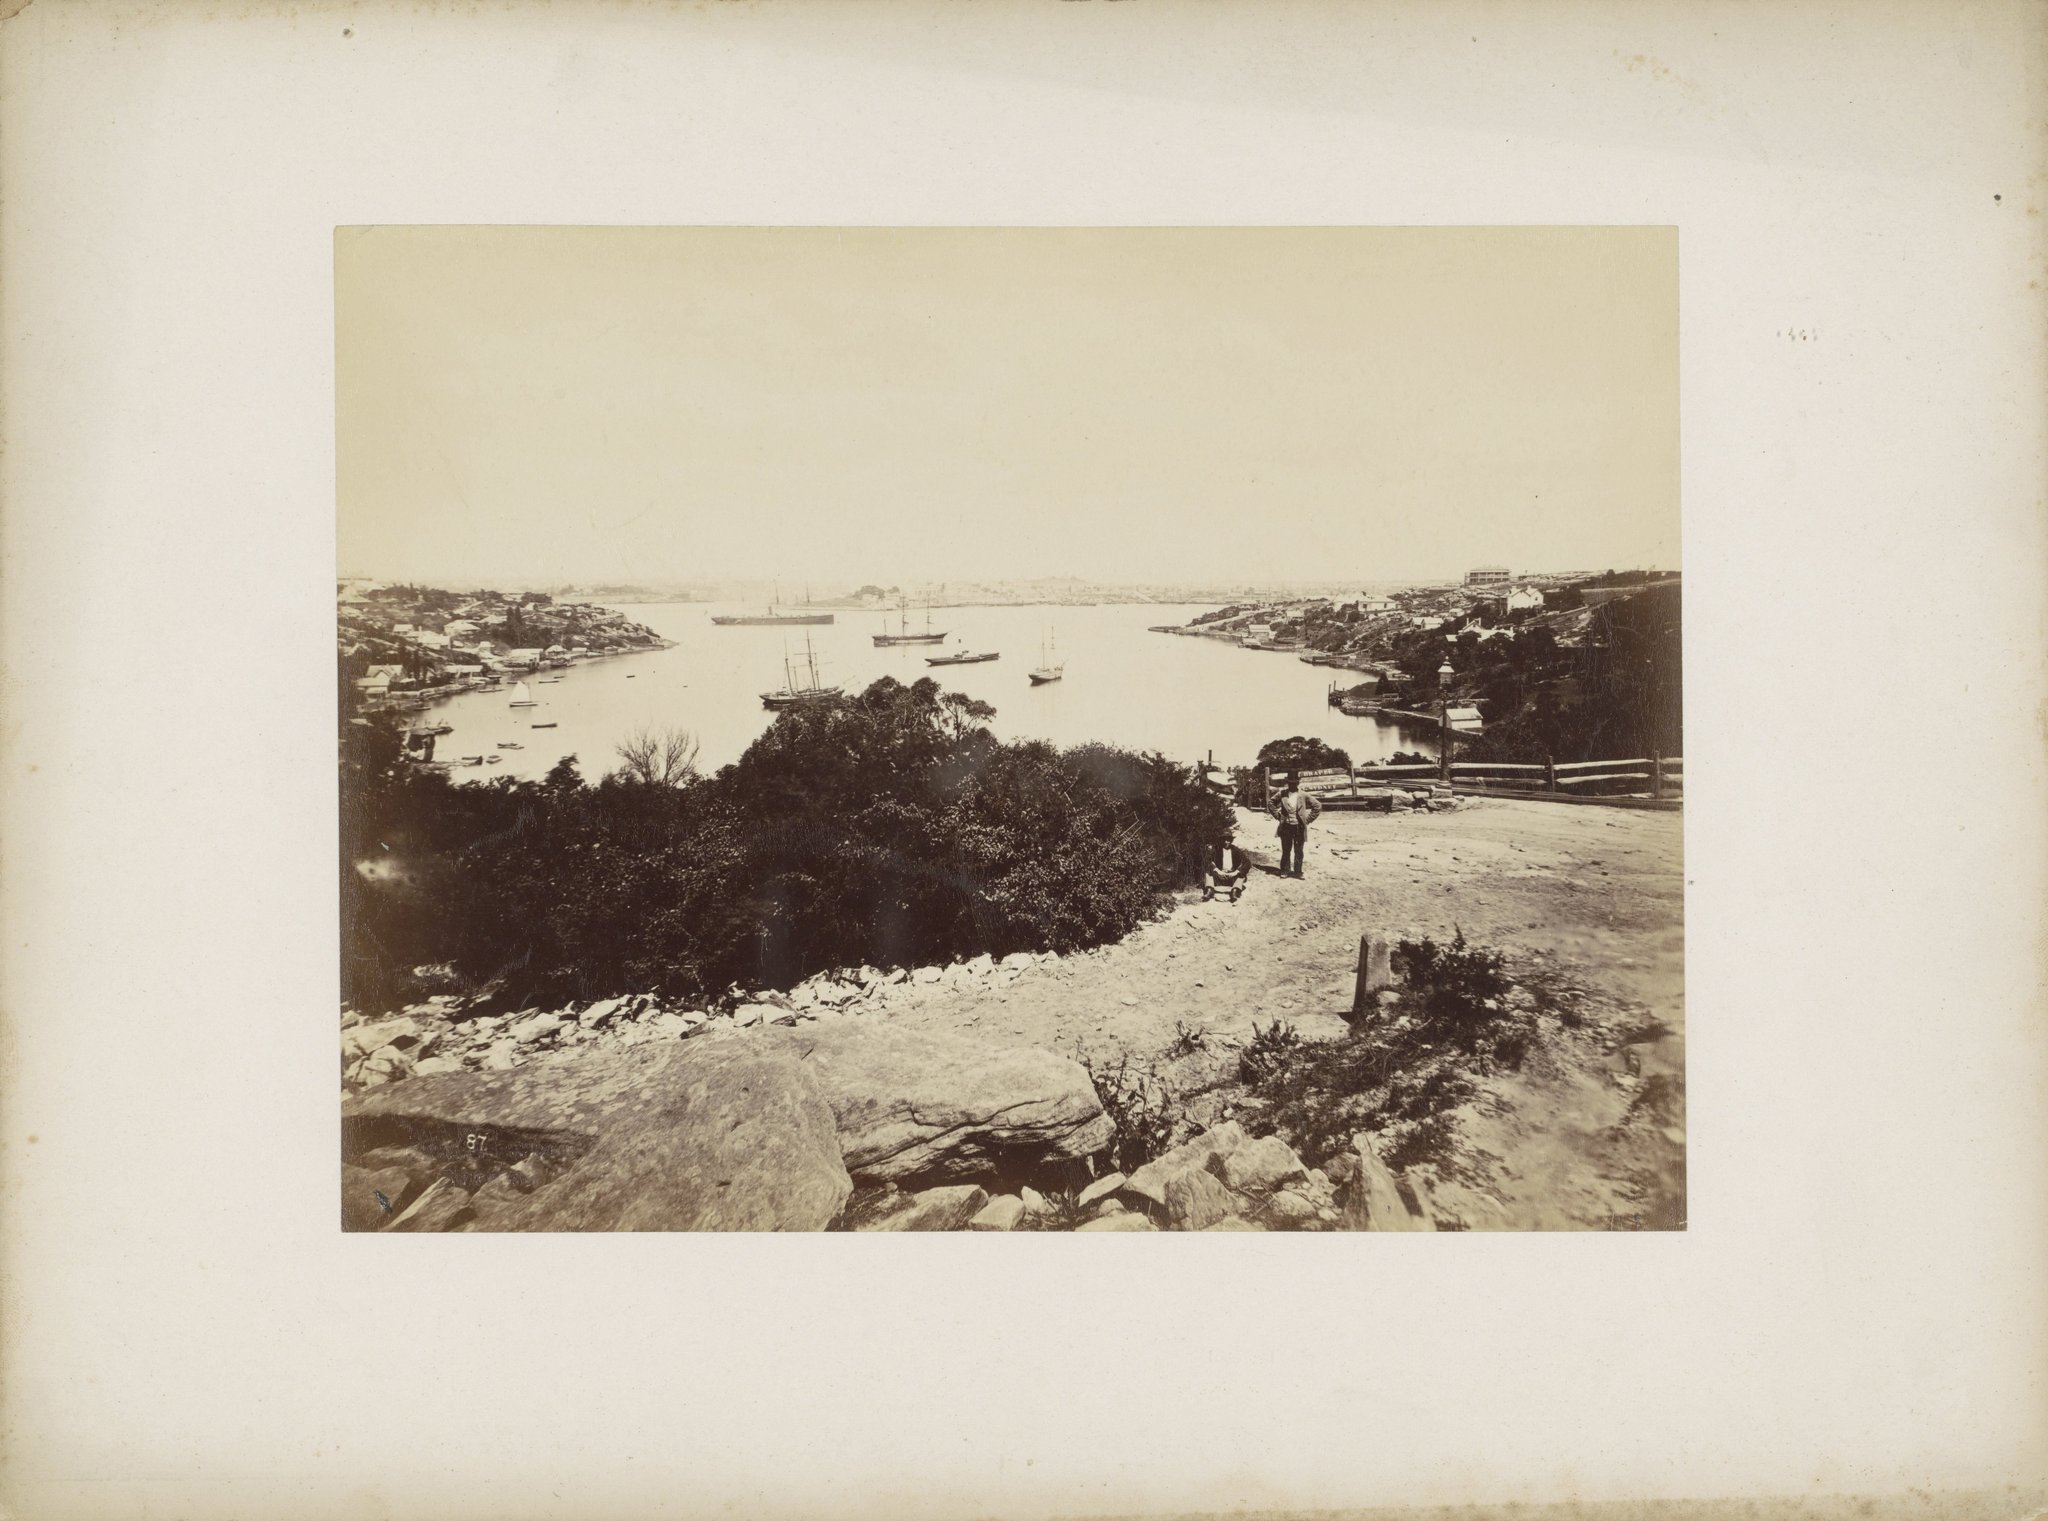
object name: album leaf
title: Gezicht op de haven van Sydney met op de voorgrond twee mannen op rotsachtig terrein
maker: charles bayliss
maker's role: fotograaf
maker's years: 1850-1897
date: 1890-1910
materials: cardboard, paper, photographic support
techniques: albumen print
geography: sydney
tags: harbour (+ view ~ vehicle, ship, etc.)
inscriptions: negative number: ‘87’, check stamp: ‘C. Bayliss Photo Sydney’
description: Onderdeel van Reisalbum met foto's van bezienswaardigheden in Sydney.